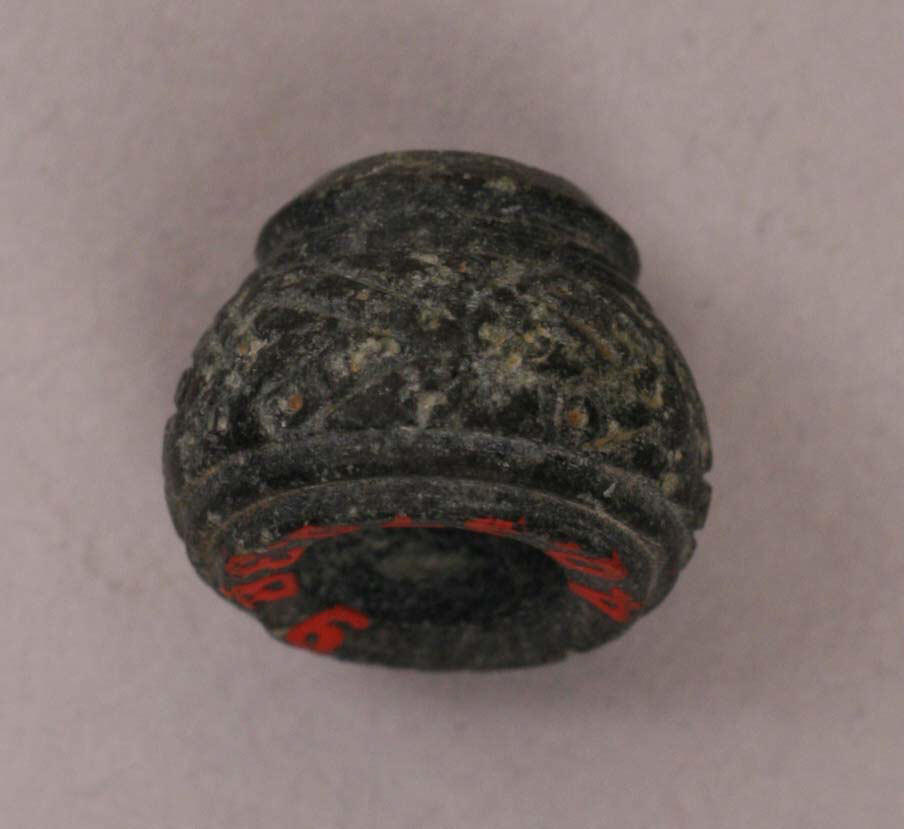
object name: button or bead or spindle whorl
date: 701-1000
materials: stone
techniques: incising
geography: iran